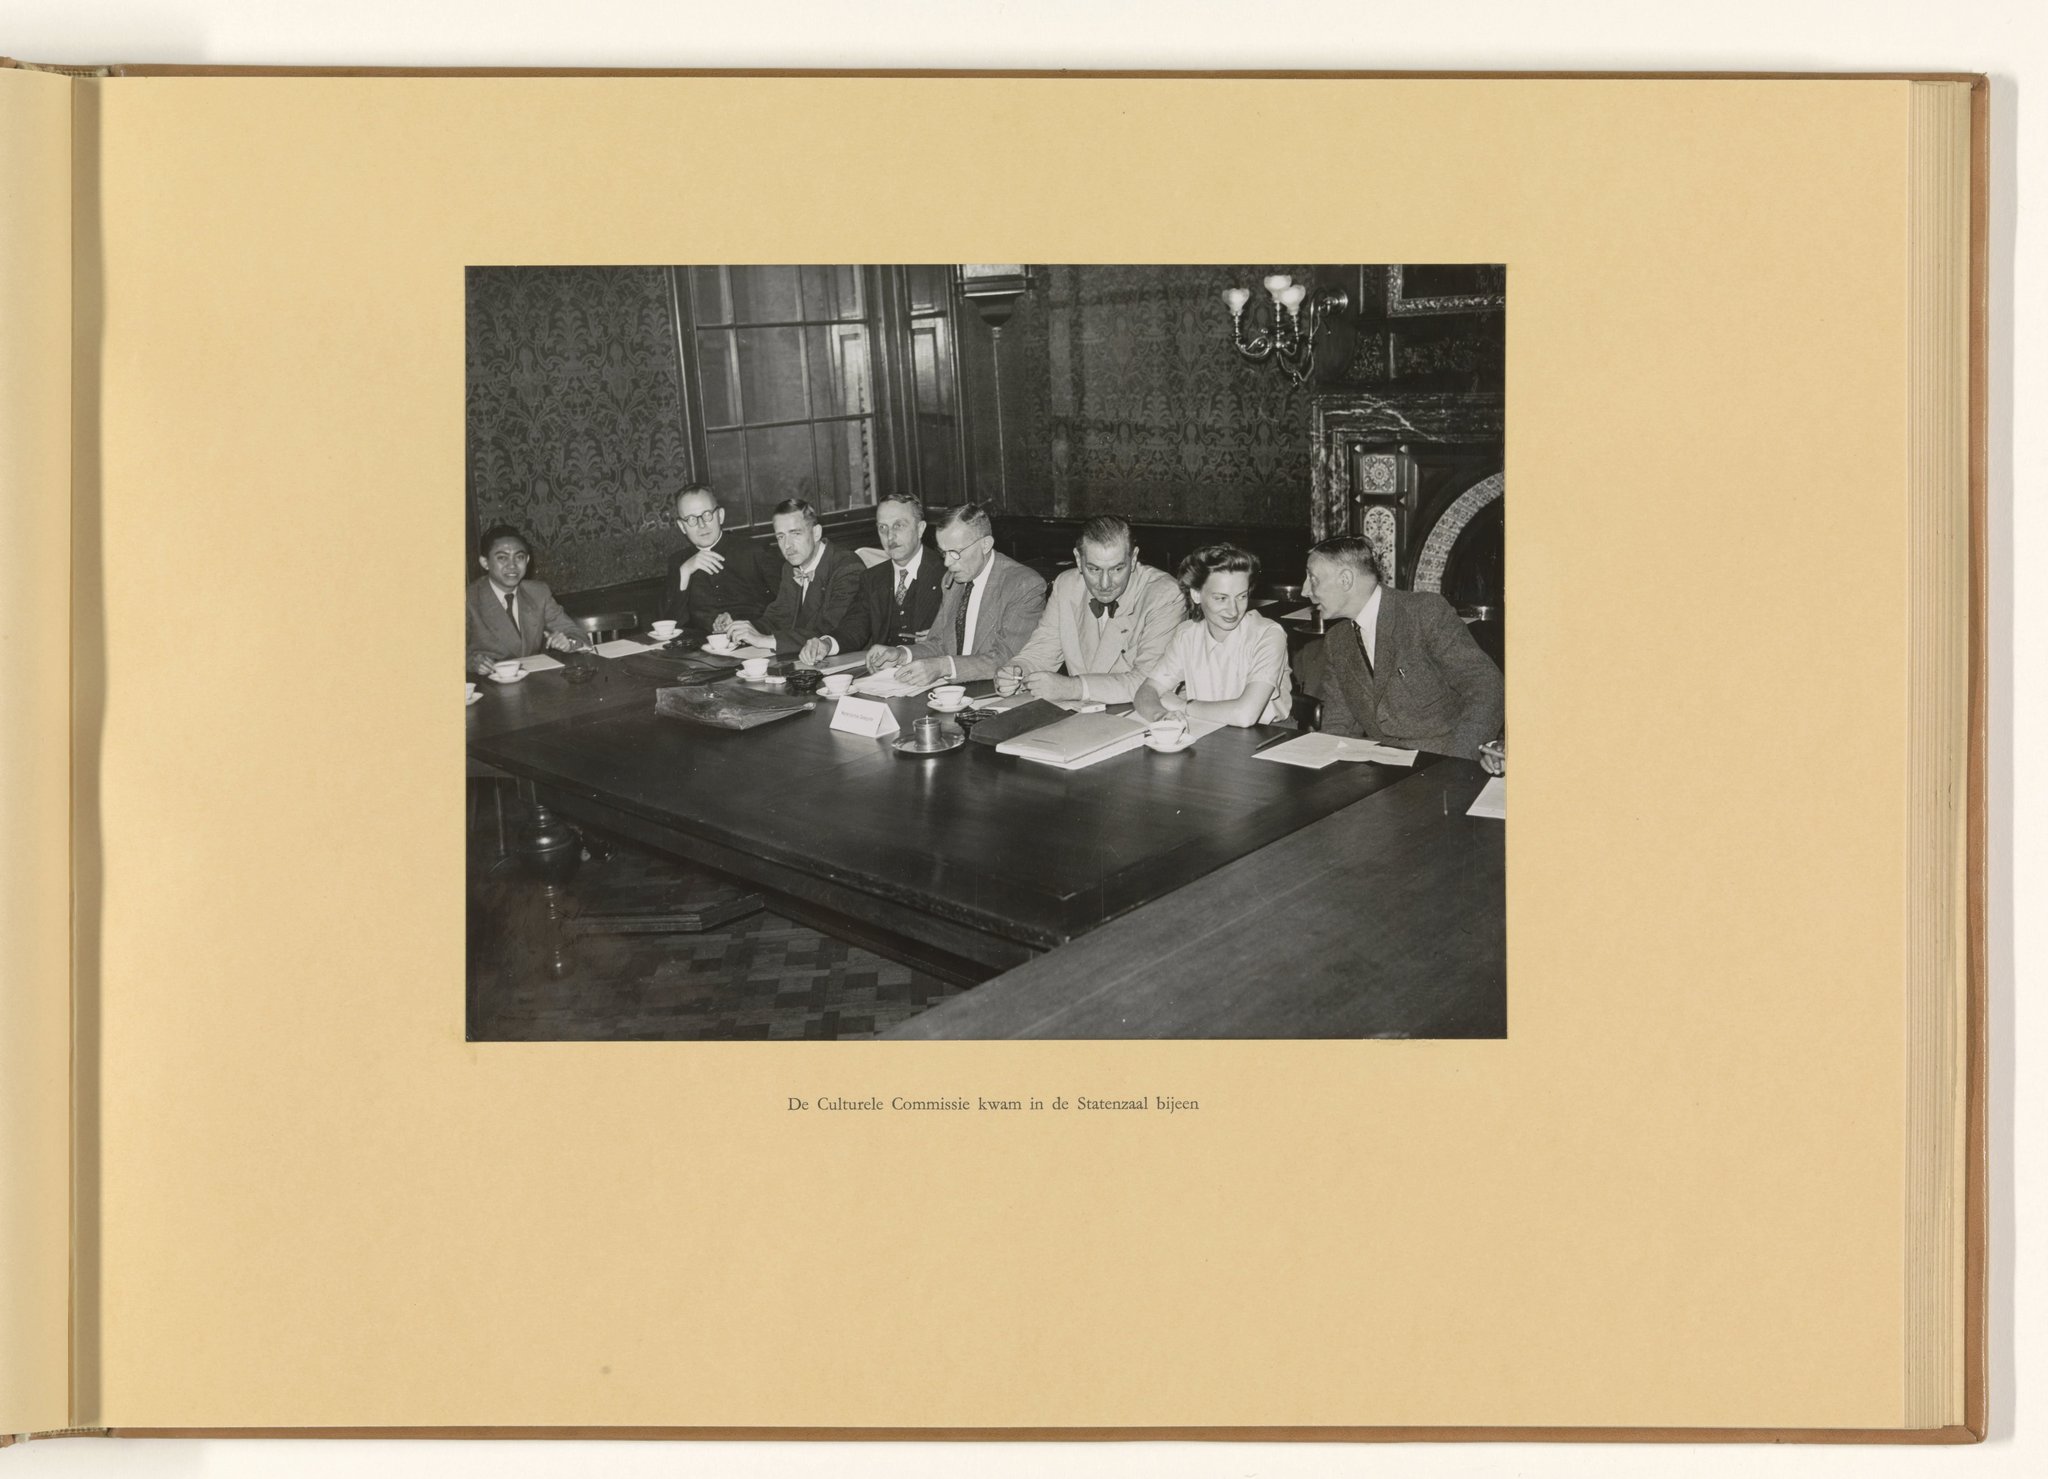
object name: photograph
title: De Culturele Commissie kwam in de Statenzaal bijeen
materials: paper, photographic support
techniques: gelatin silver print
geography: the hague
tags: statenzaal (den haag), rondetafelconferentie (1949)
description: De Culturele Commissie aan het werk in de Statenzaal. Foto in het fotoalbum met 37 foto's van de rondetafelconferentie gehouden tussen 23 augustus en 2 november in Den Haag in 1949 tussen vertegenwoordigers van Nederland, de Republiek Indonesië en de Bijeenkomst Federaal Overleg. Het exemplaar aangeboden aan premier Willem Drees.